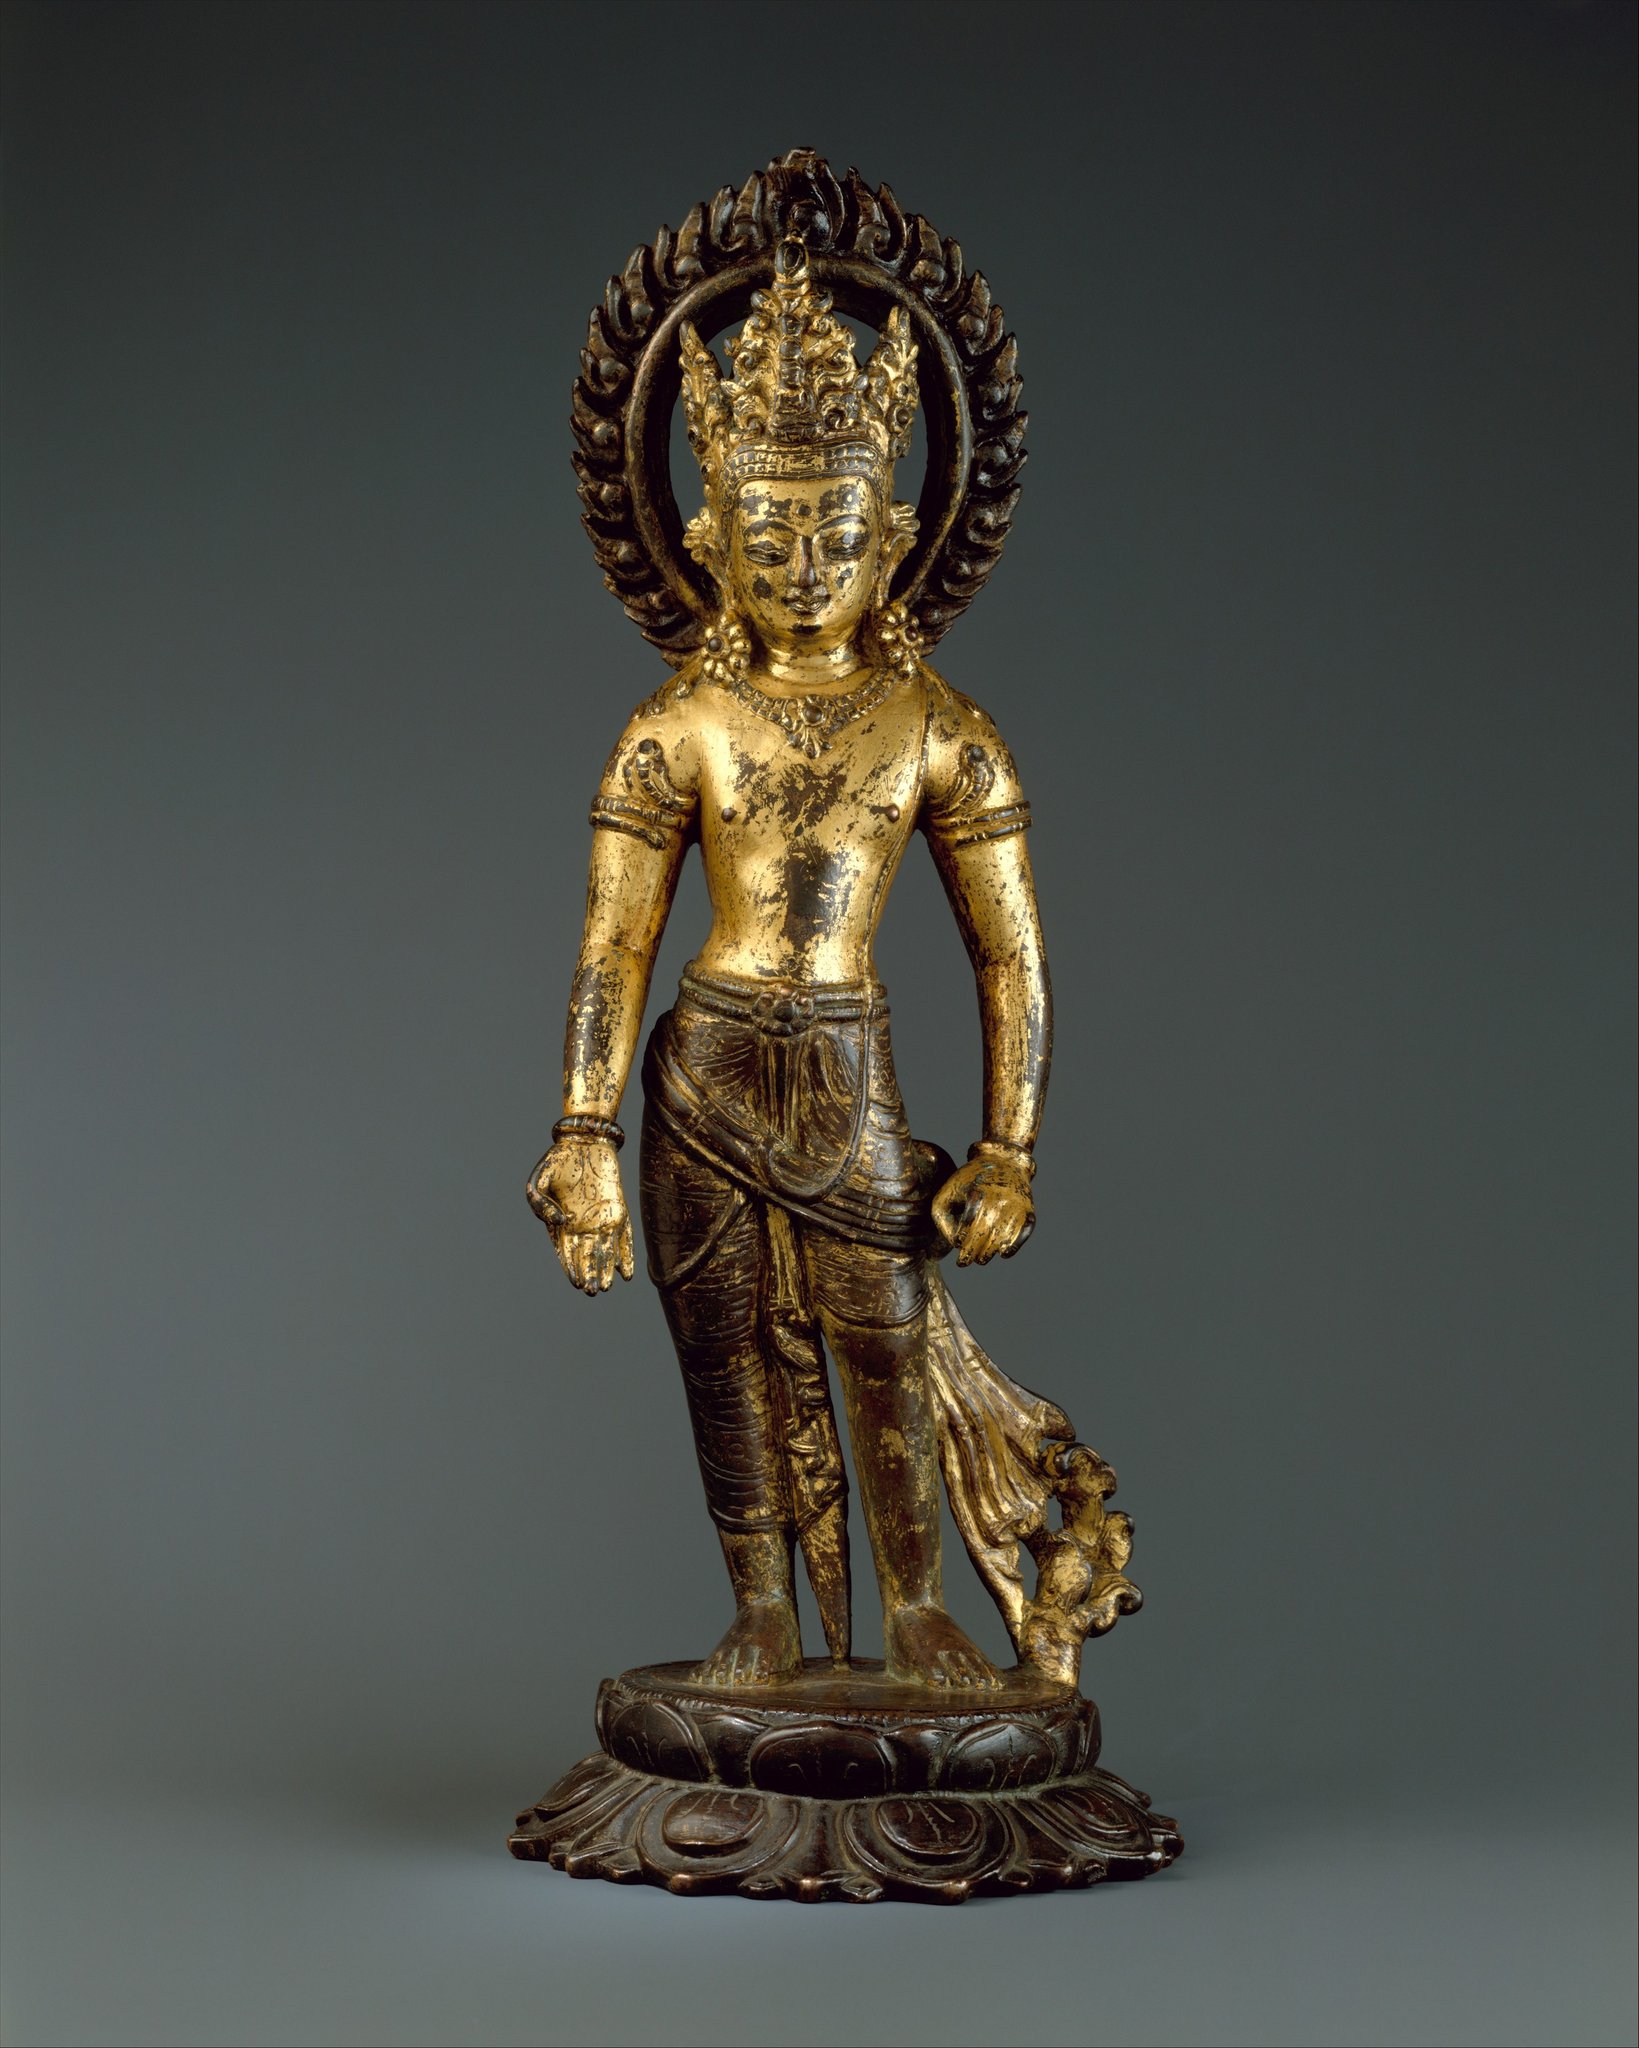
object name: figure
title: Avalokiteshvara, the Bodhisattva of Infinite Compassion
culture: nepali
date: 901-1000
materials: copper alloy, gilt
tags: buddhism,avalokiteshvara,bodhisattvas